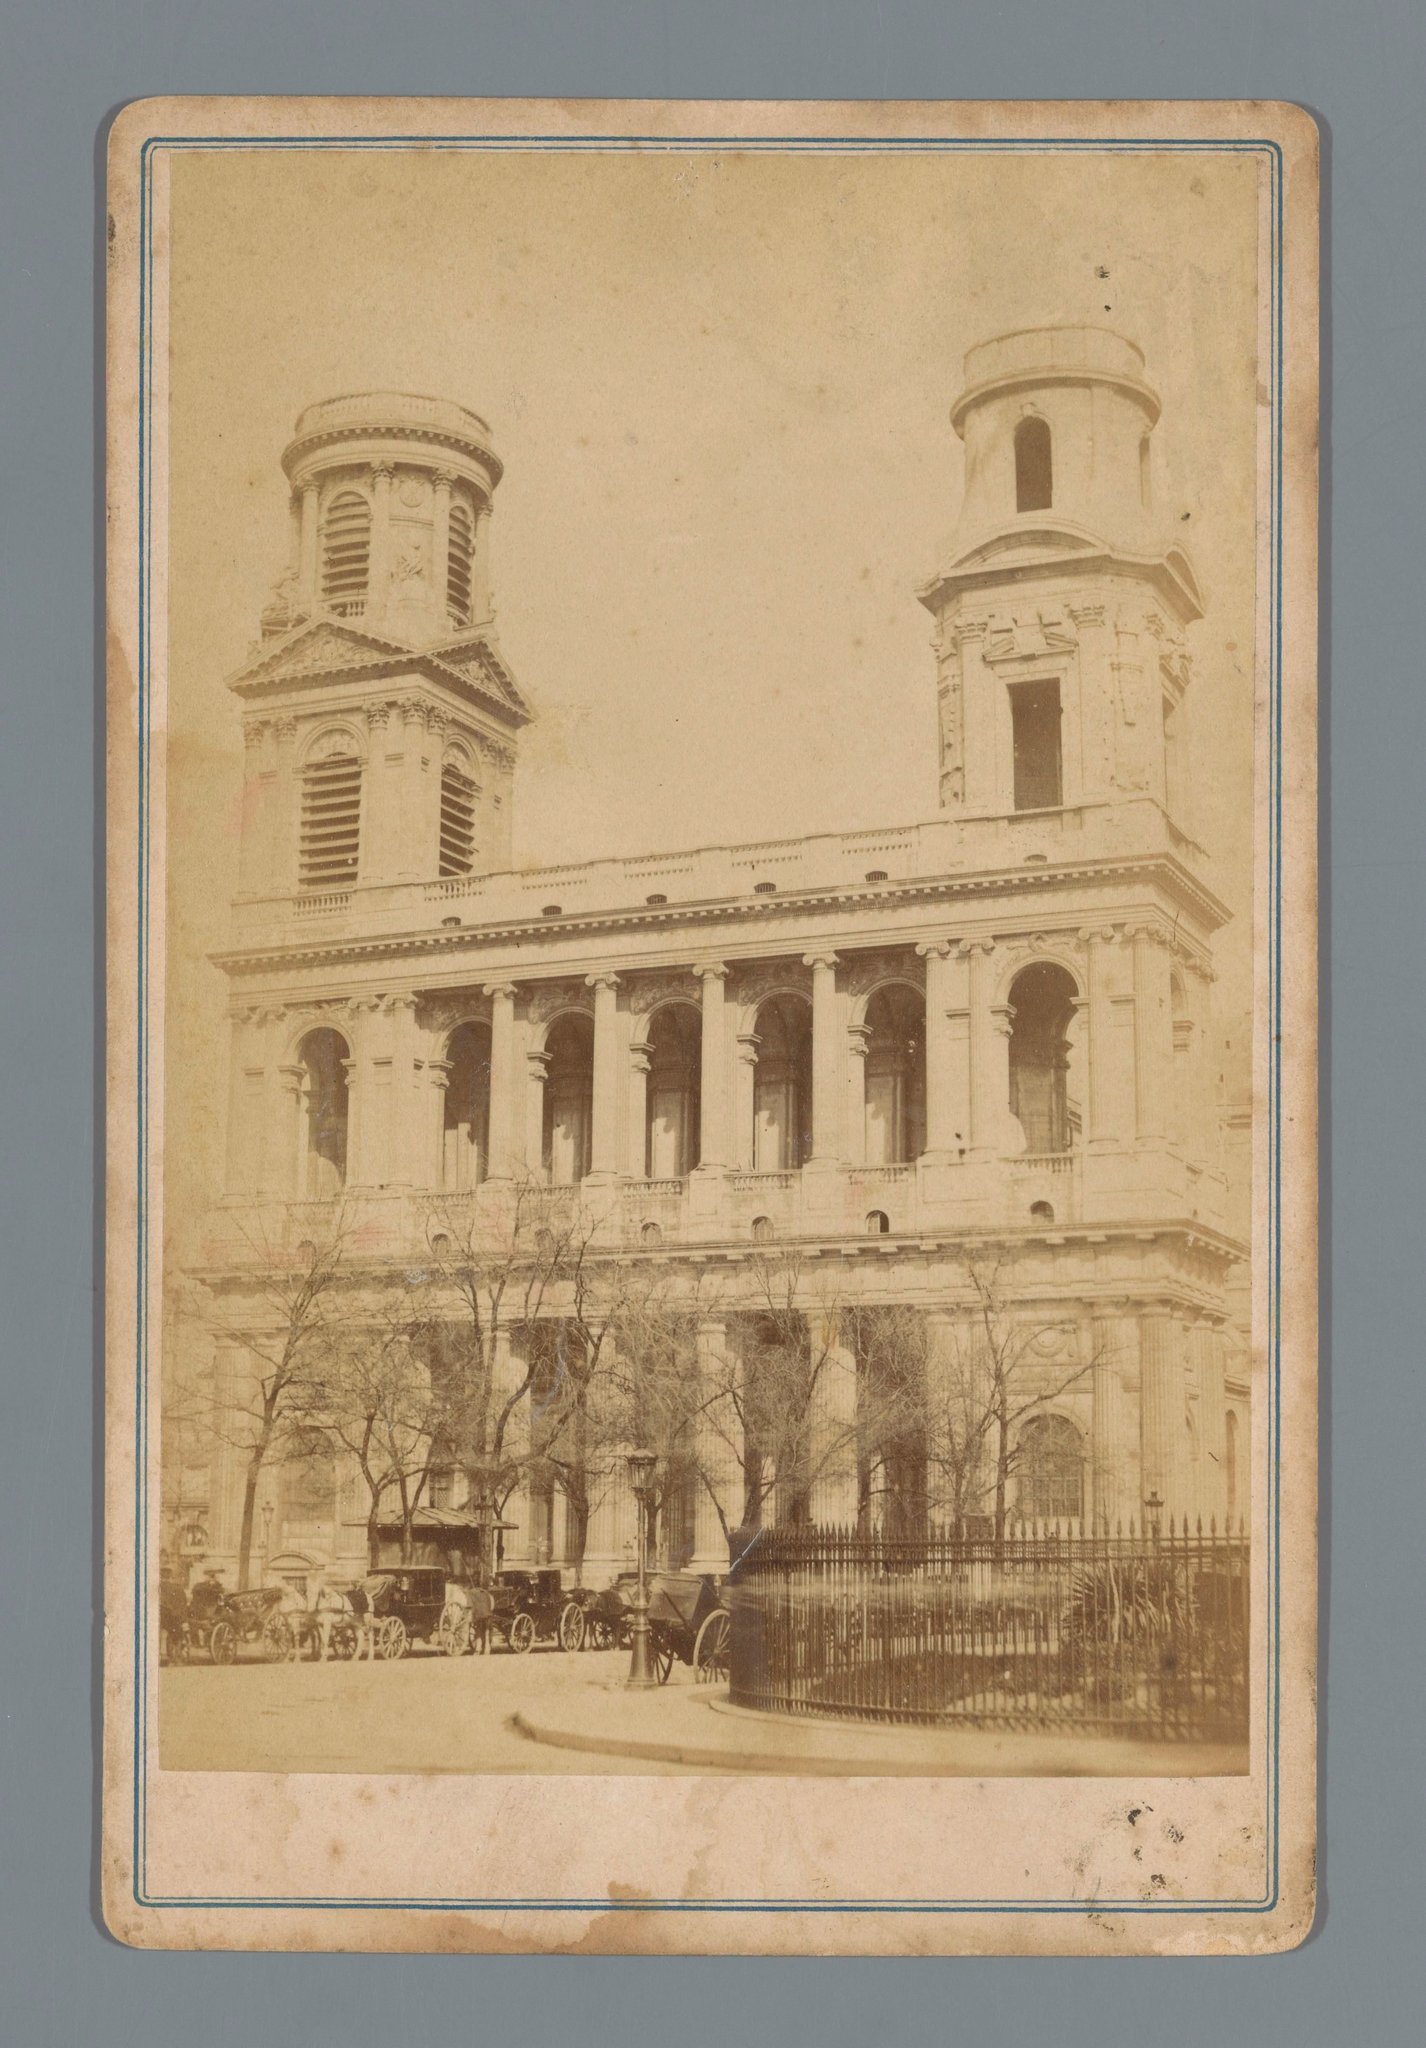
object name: cabinet photograph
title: Gezicht op de Saint-Sulpice te Parijs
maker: Anonymous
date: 1860-1890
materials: cardboard, photographic support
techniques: albumen print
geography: paris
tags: church (exterior), façade (of house or building)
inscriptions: annotation: ‘Eglise st Sulpice’